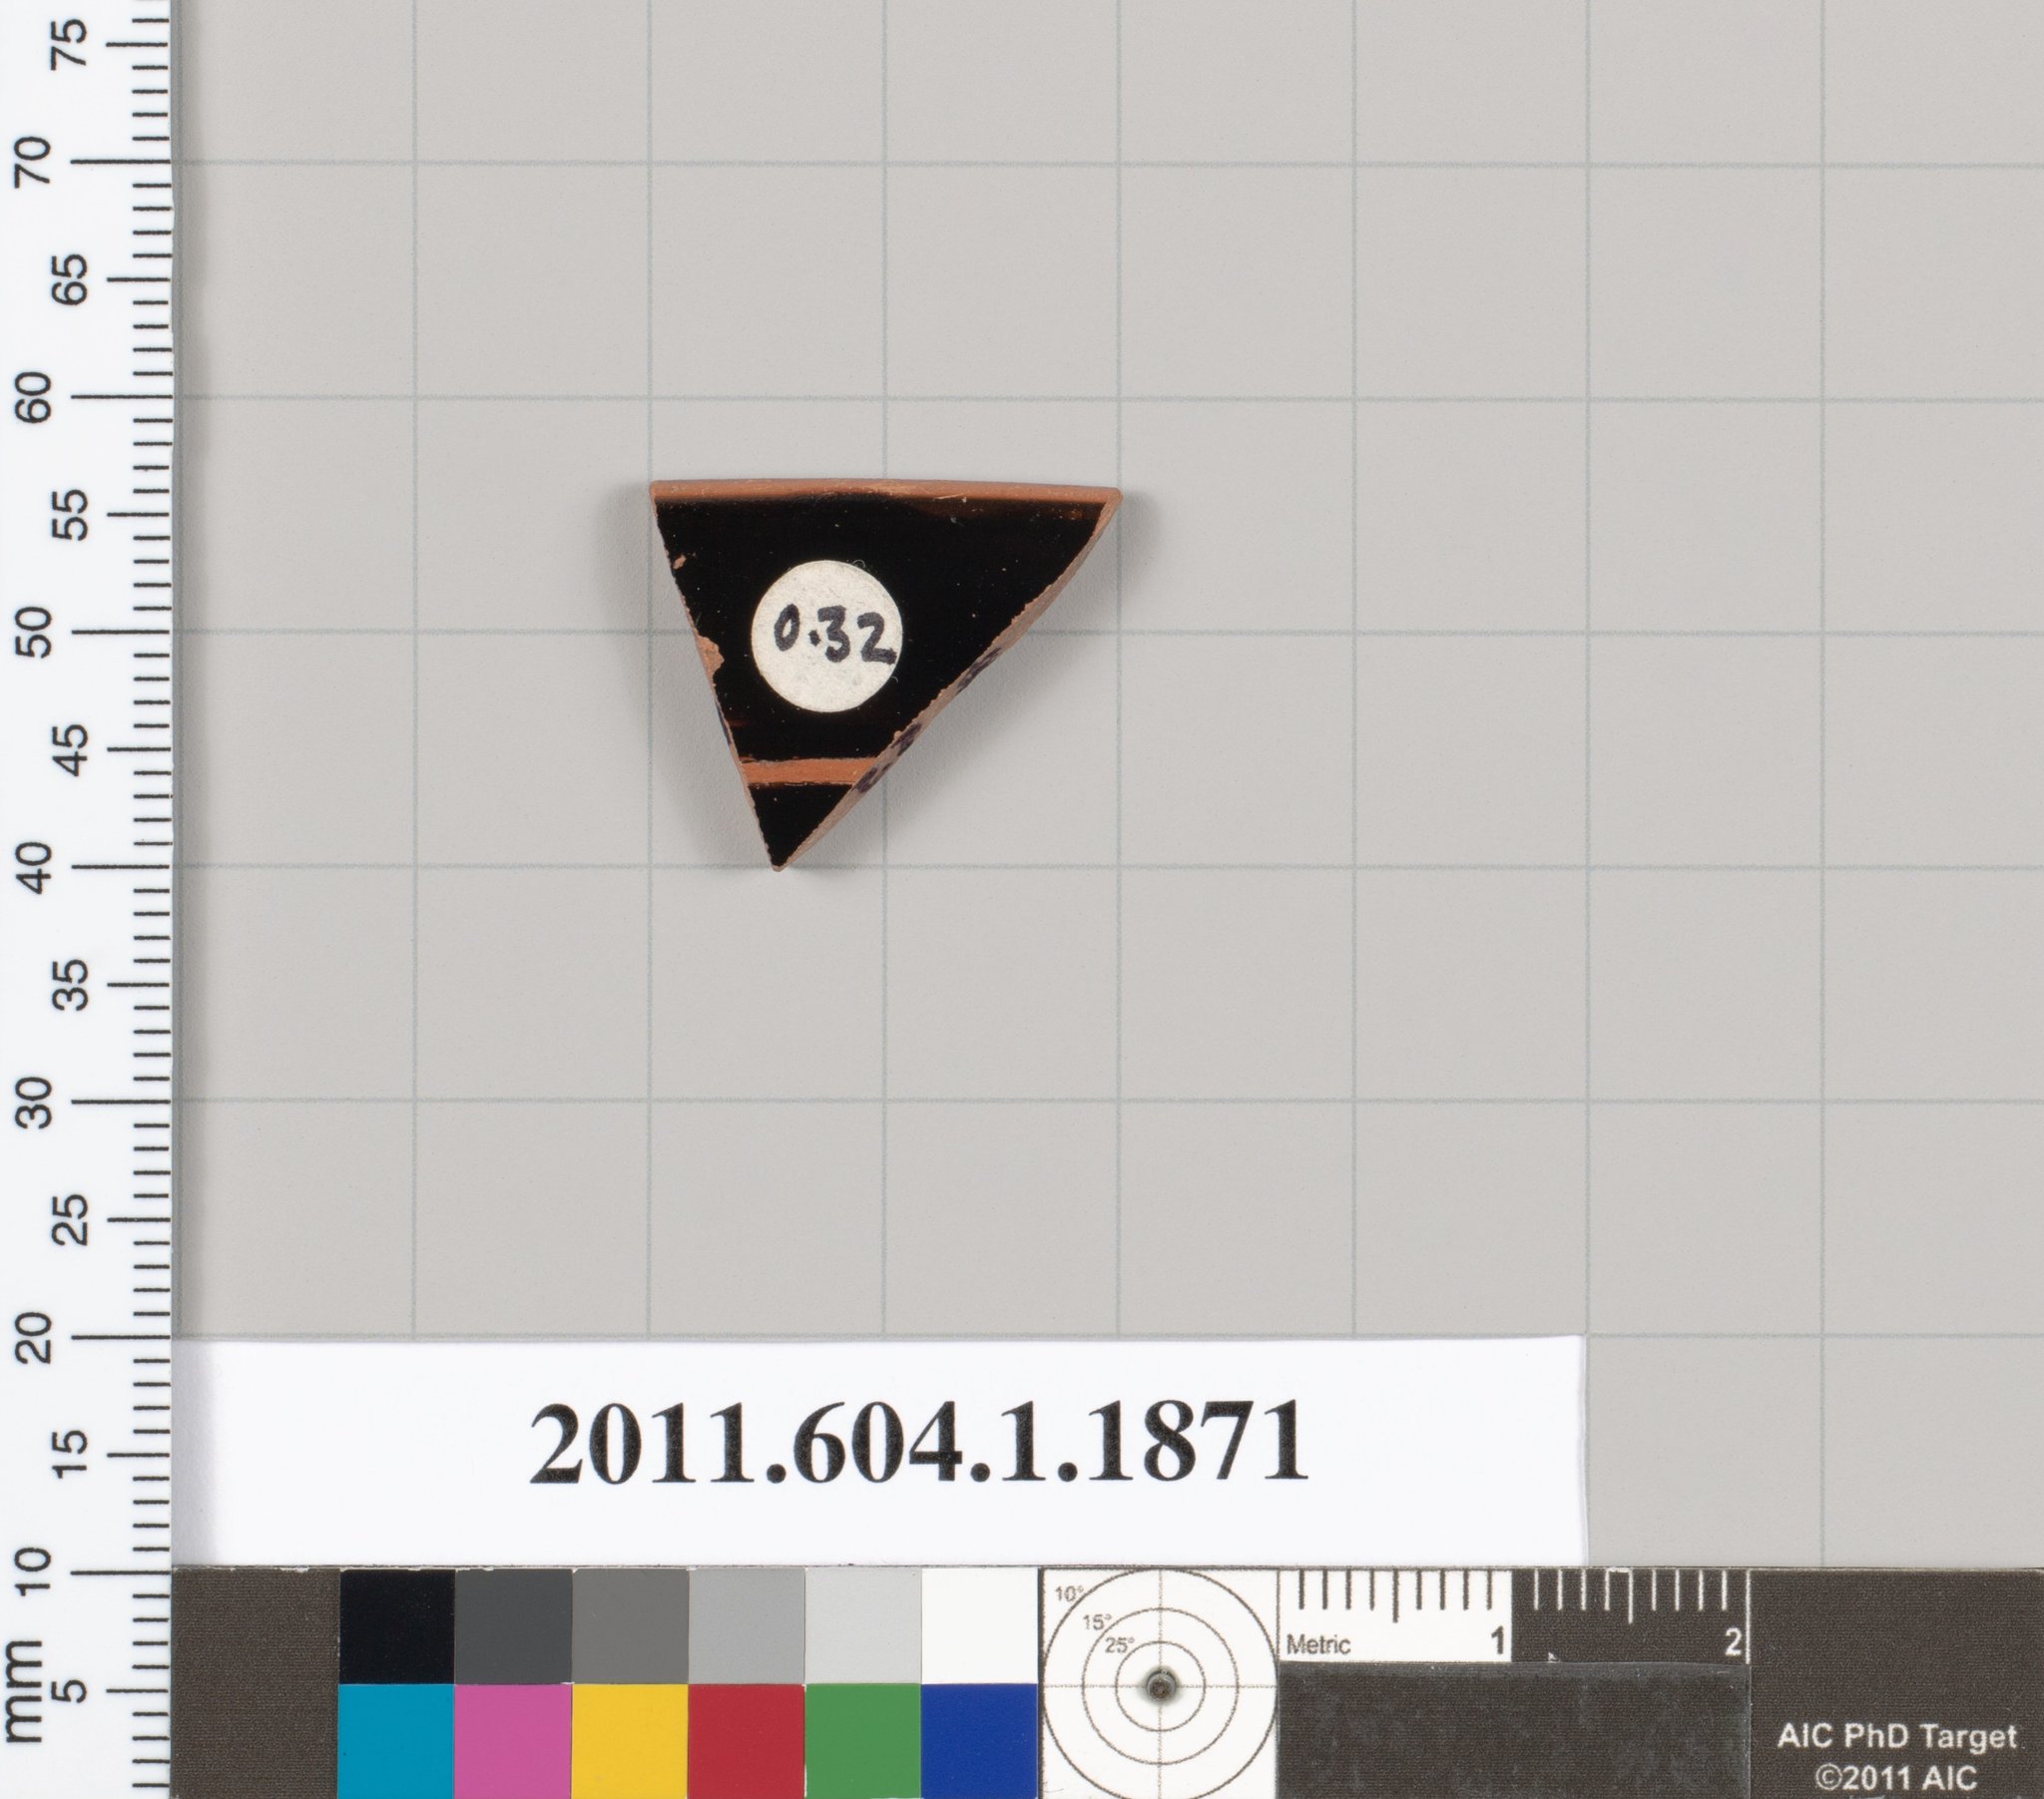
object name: kylix fragment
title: Terracotta rim fragment of a kylix (drinking cup)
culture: greek, attic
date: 490-480 BCE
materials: terracotta